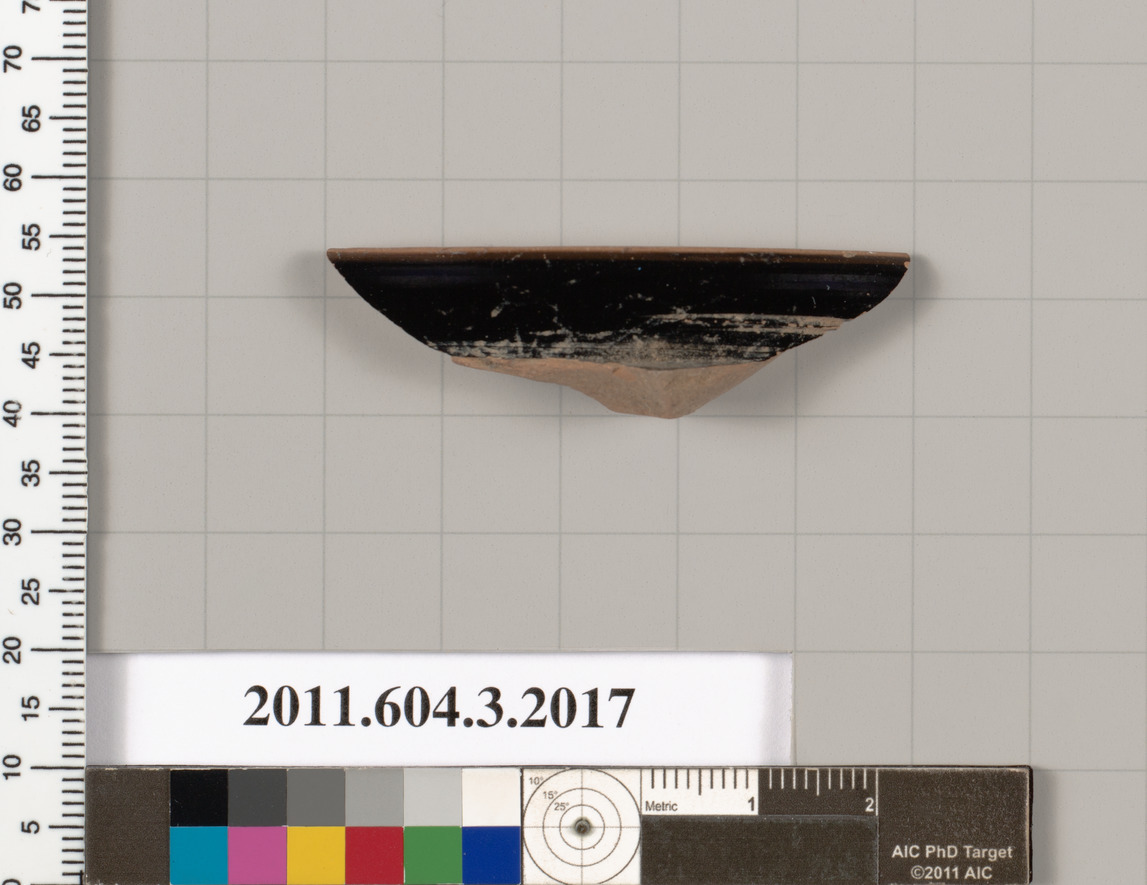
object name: kylix fragment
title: Terracotta fragment of a kylix (drinking cup)?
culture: greek, attic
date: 550-501 BCE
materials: terracotta